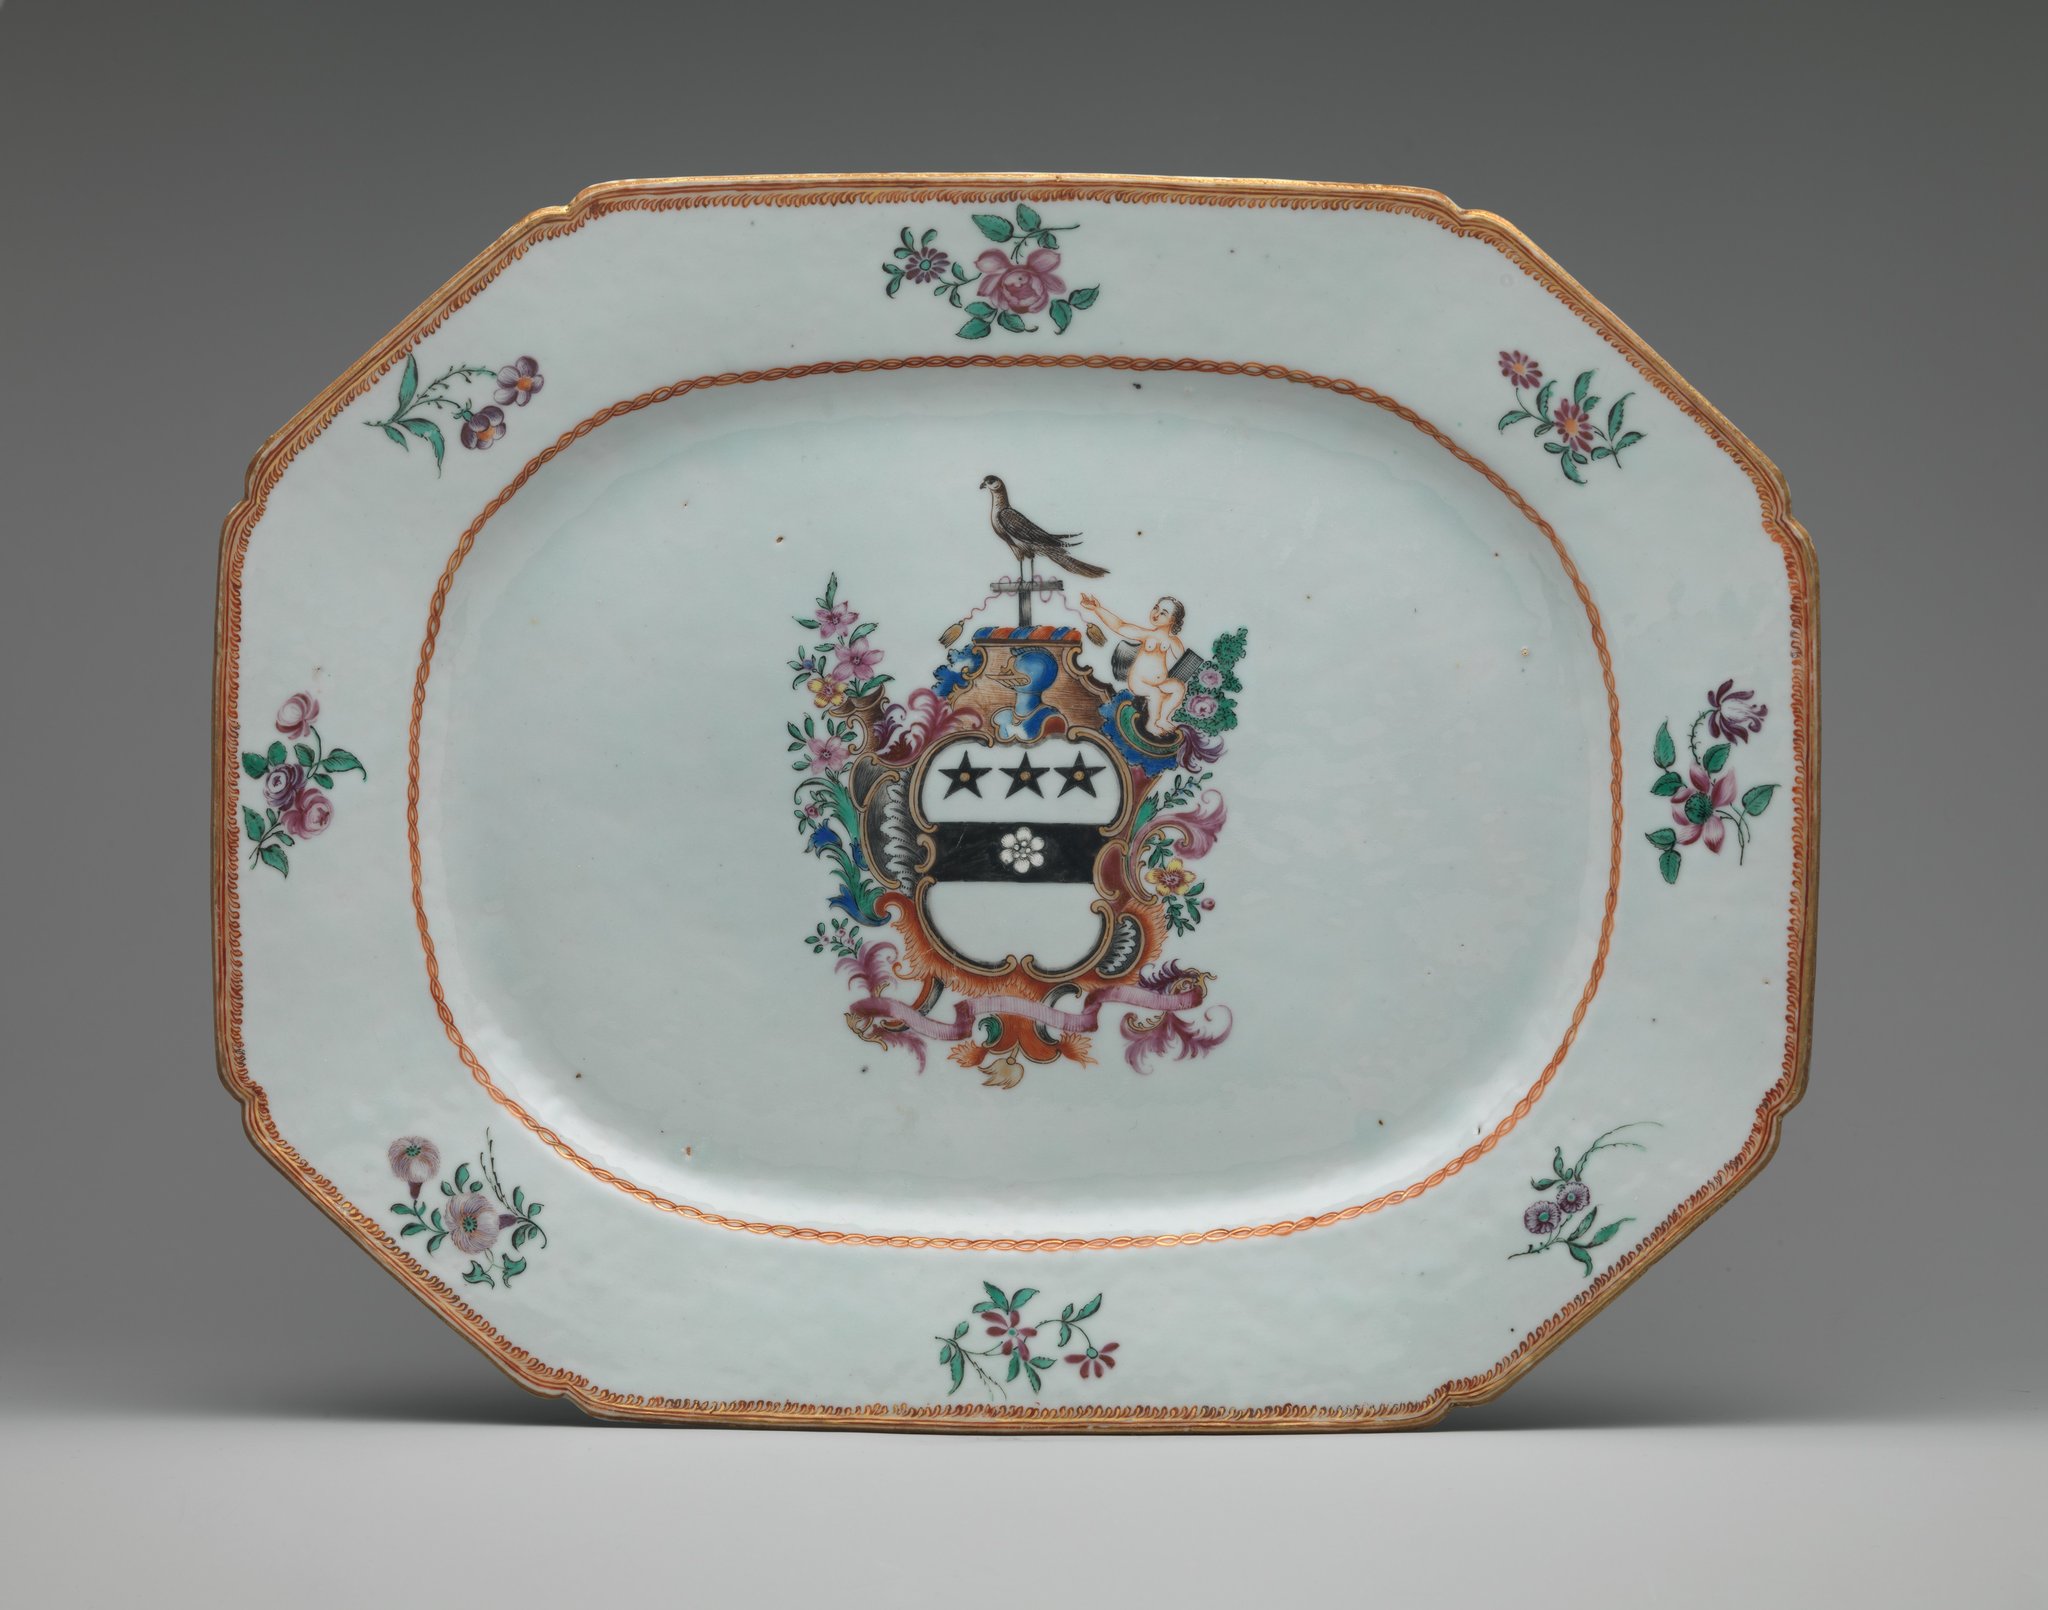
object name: platter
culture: chinese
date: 1785-1790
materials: porcelain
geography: china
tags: birds,coat of arms